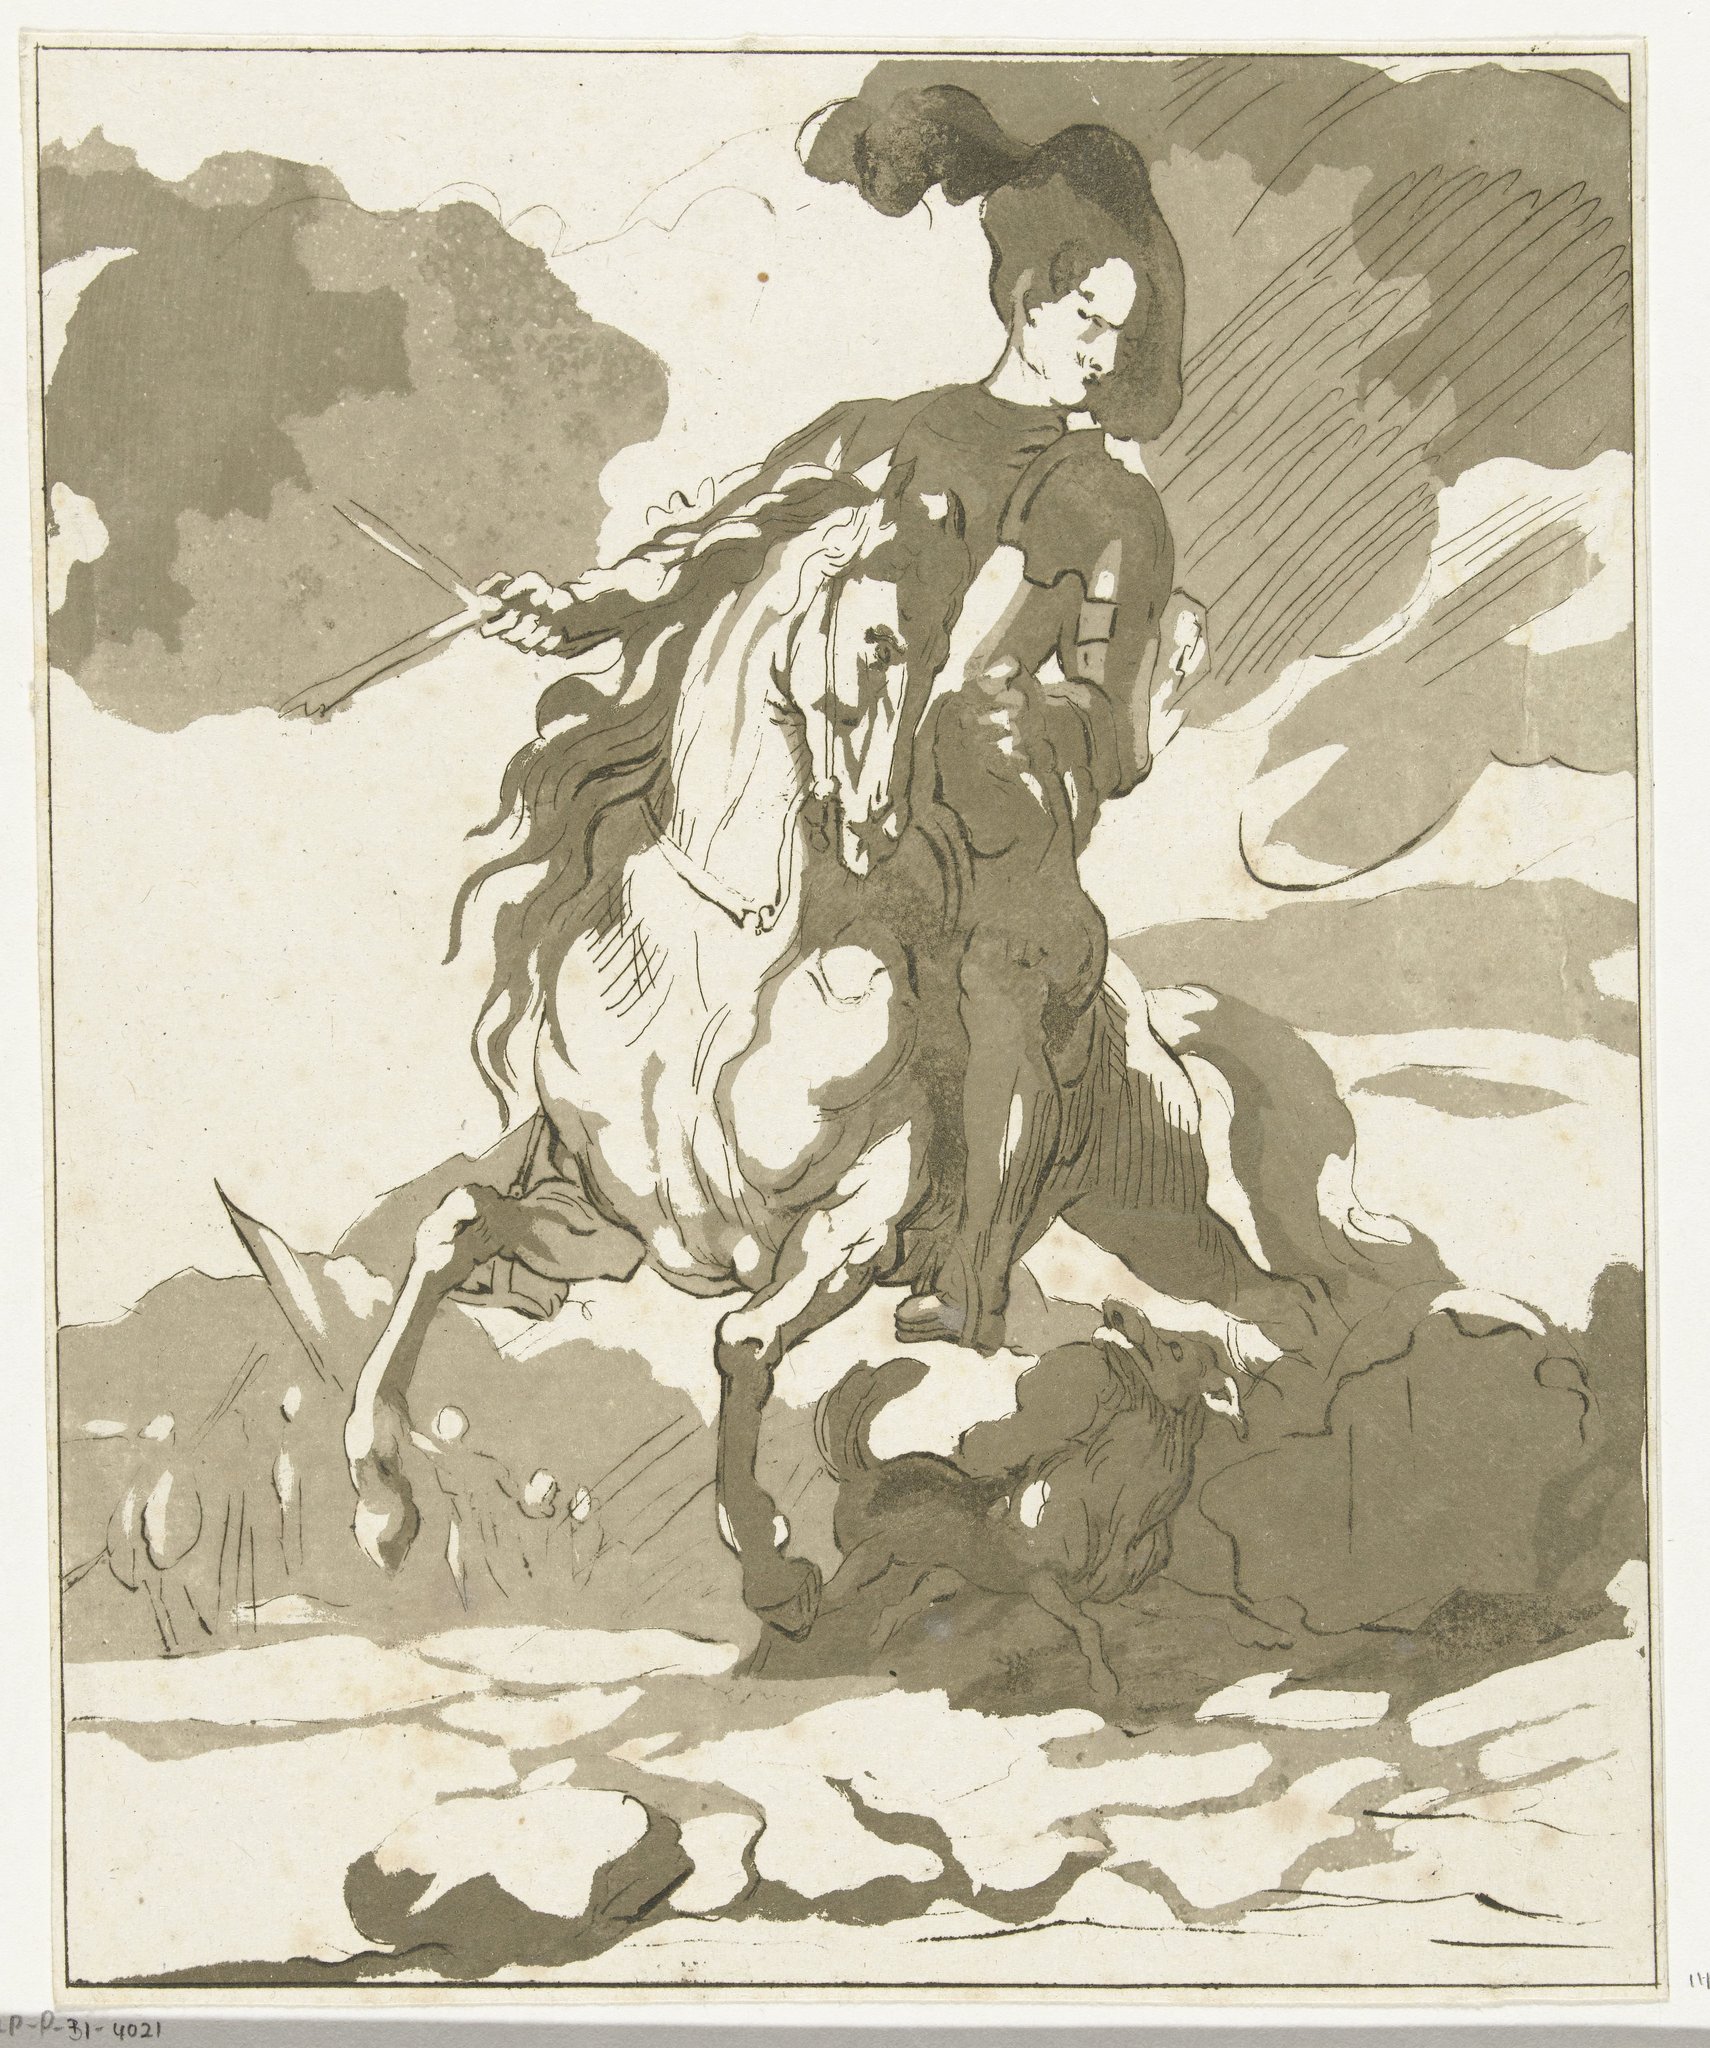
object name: print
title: Ruiter met hond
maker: anthonie van den bos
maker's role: draughtsman, print maker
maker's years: 1763-1838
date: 1778-1838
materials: paper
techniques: aquatint, etching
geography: netherlands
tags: riding a horse, ass, or mule; rider, horseman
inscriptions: collector's mark: Lugt 2228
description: Een soldaat met wapenrusting en een pluim aan zijn hoed, te paard. Een hond loopt tussen de benen van het paard. Op de achtergrond zijn oprukkende soldaten met een vlag schematisch weergegeven.